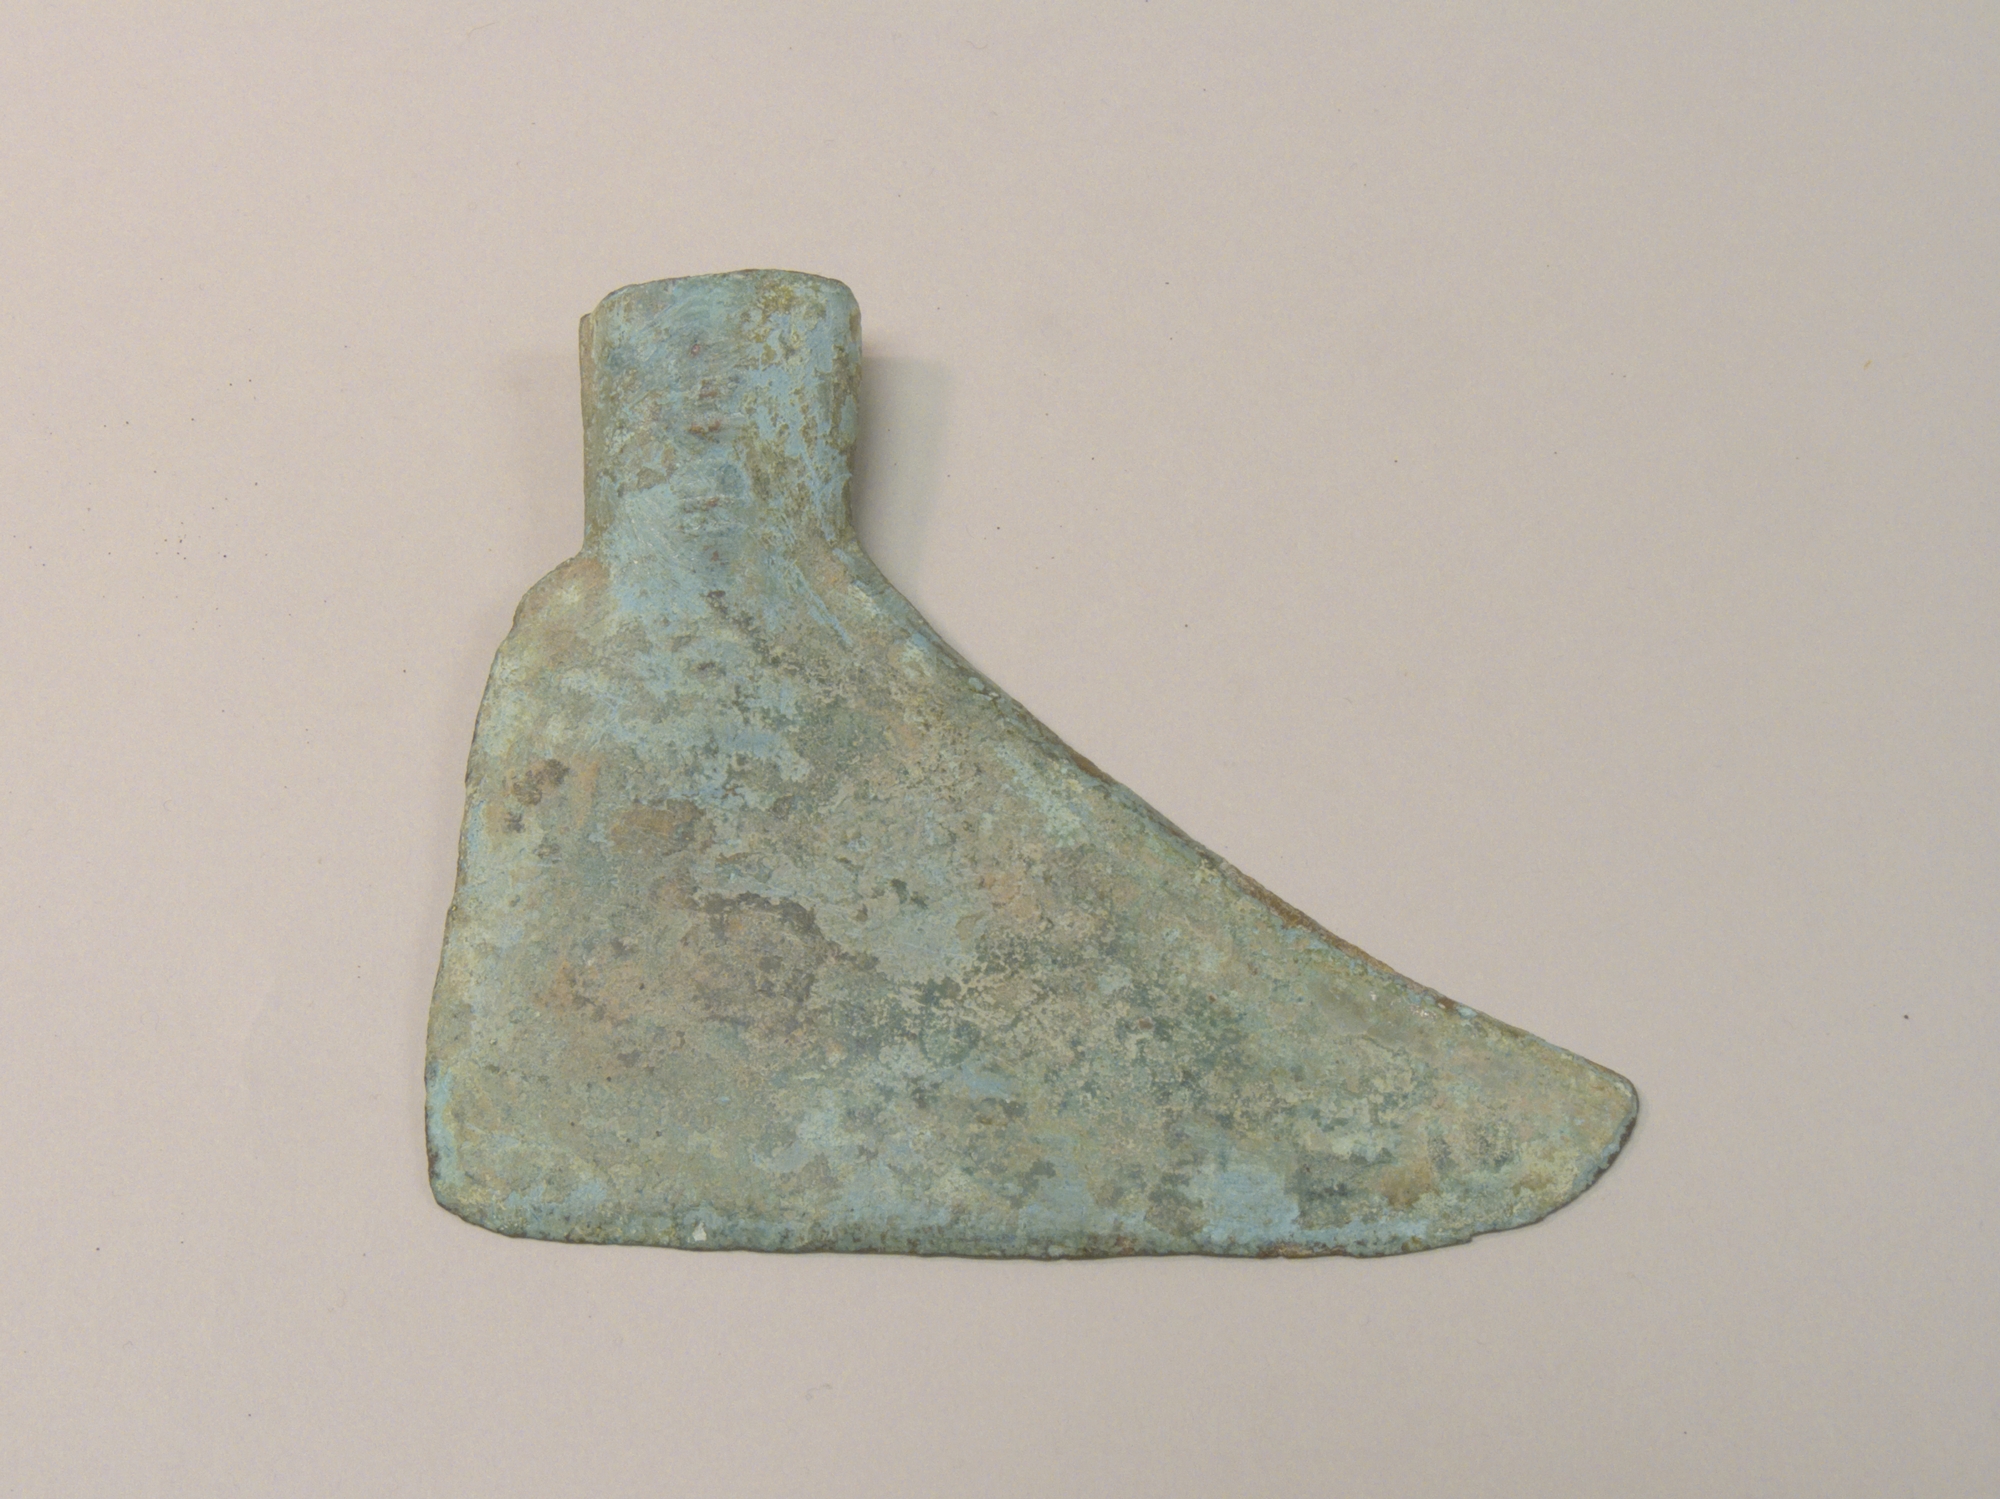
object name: hafted ax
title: Boat-Shaped Hafted Ax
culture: vietnamese, dong son culture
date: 500 BCE-300 CE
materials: bronze